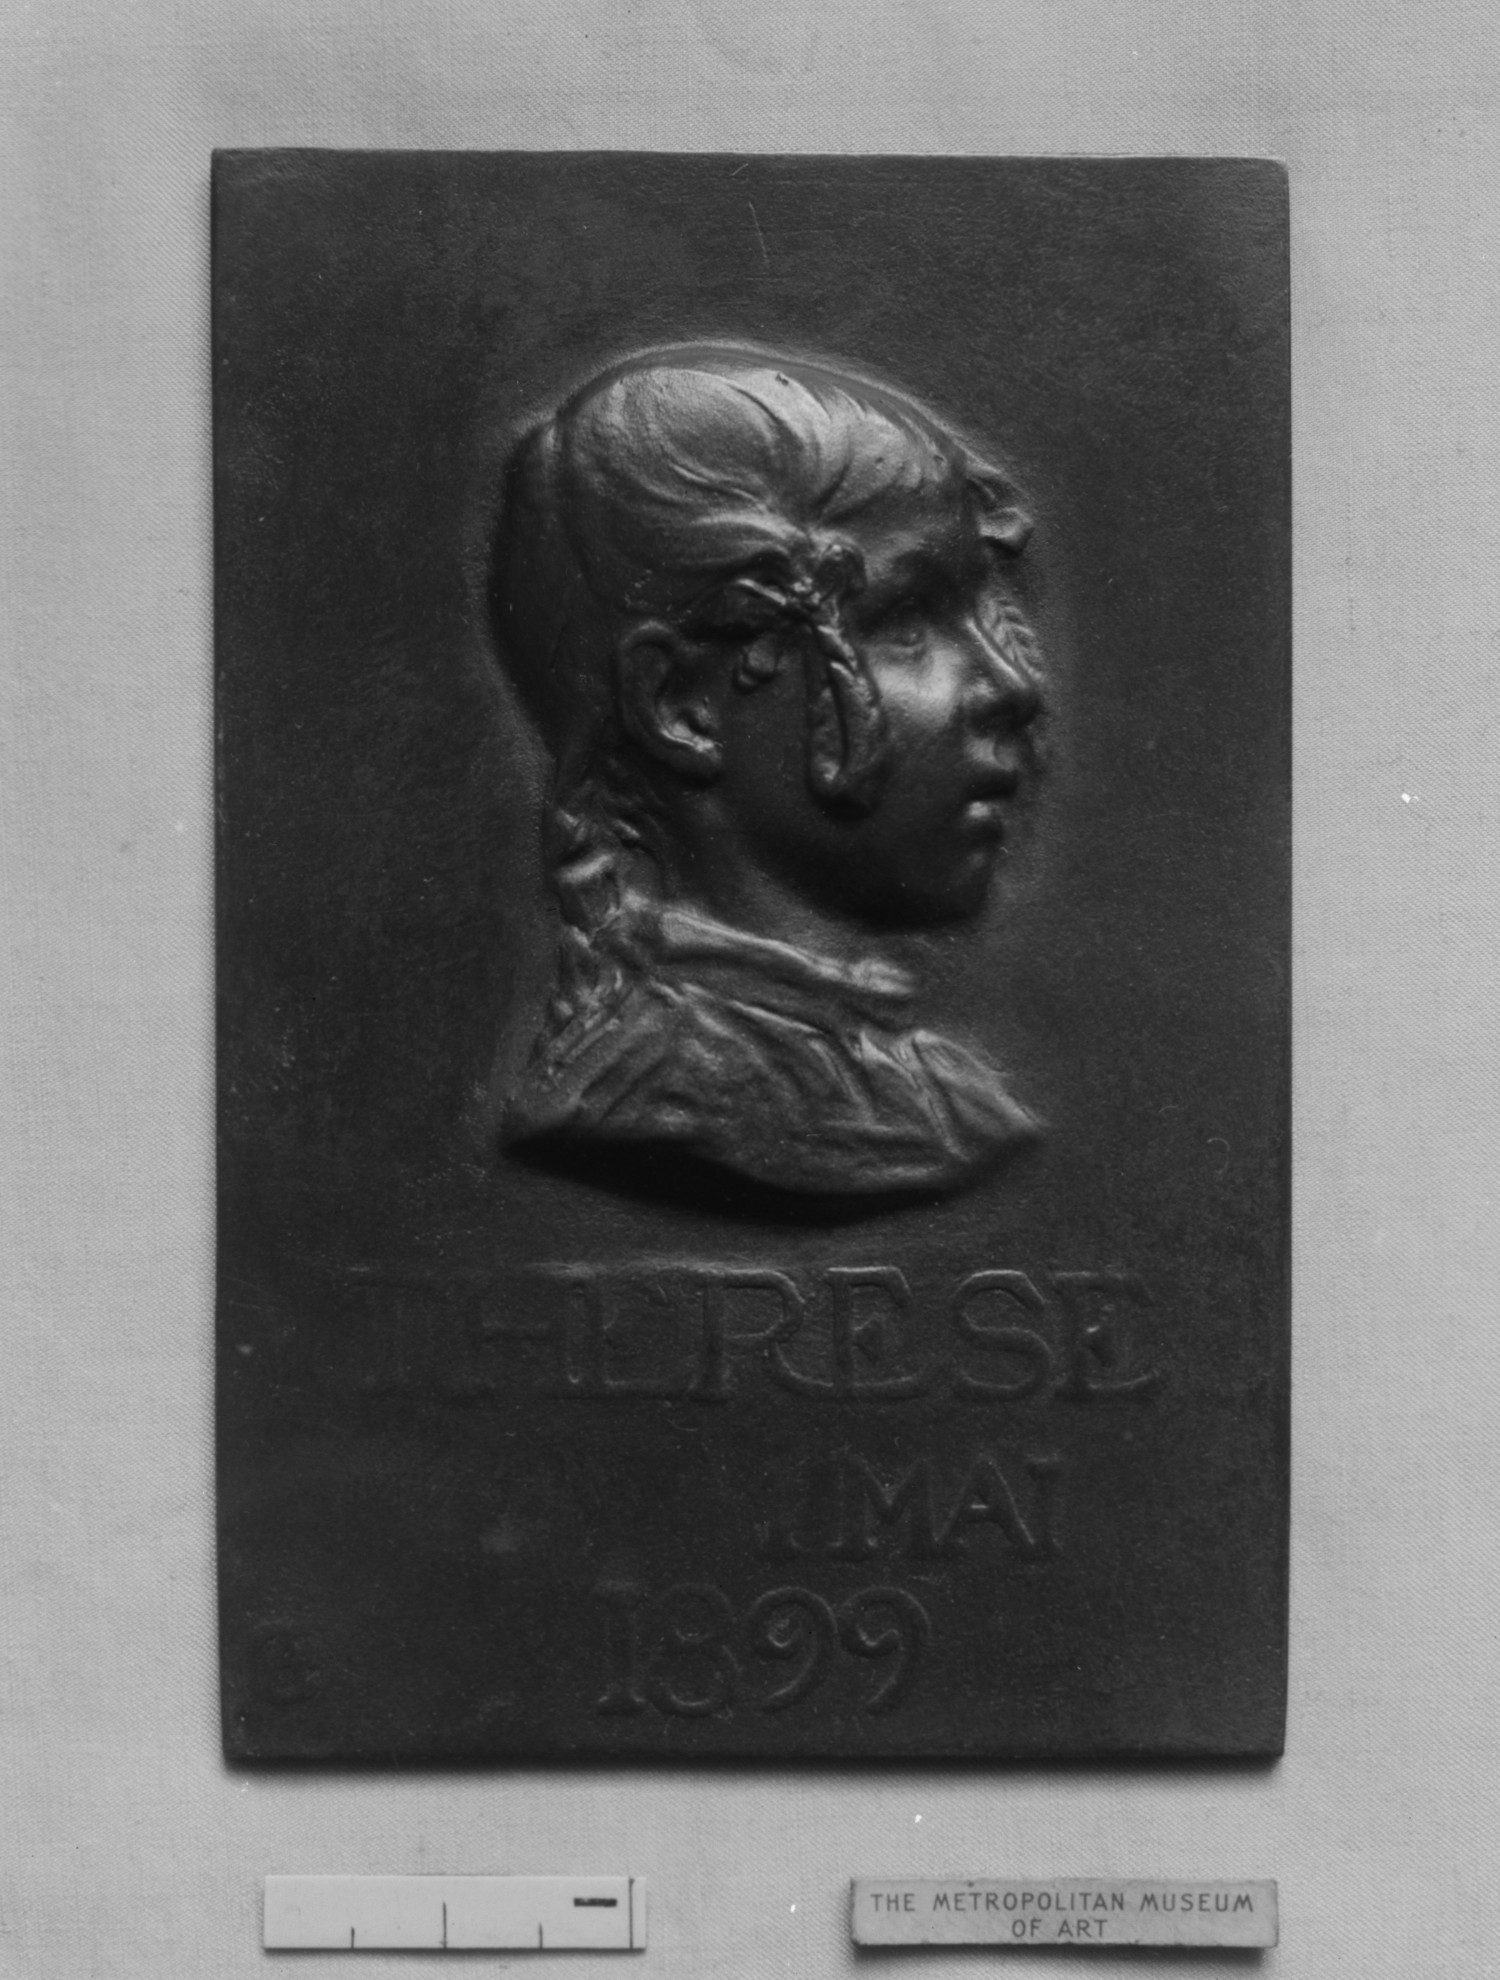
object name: plaquette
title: Therese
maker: alexandre-louis-marie charpentier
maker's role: artist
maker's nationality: french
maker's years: 1856-1909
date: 1867-1900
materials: bronze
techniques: casting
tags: profiles,women